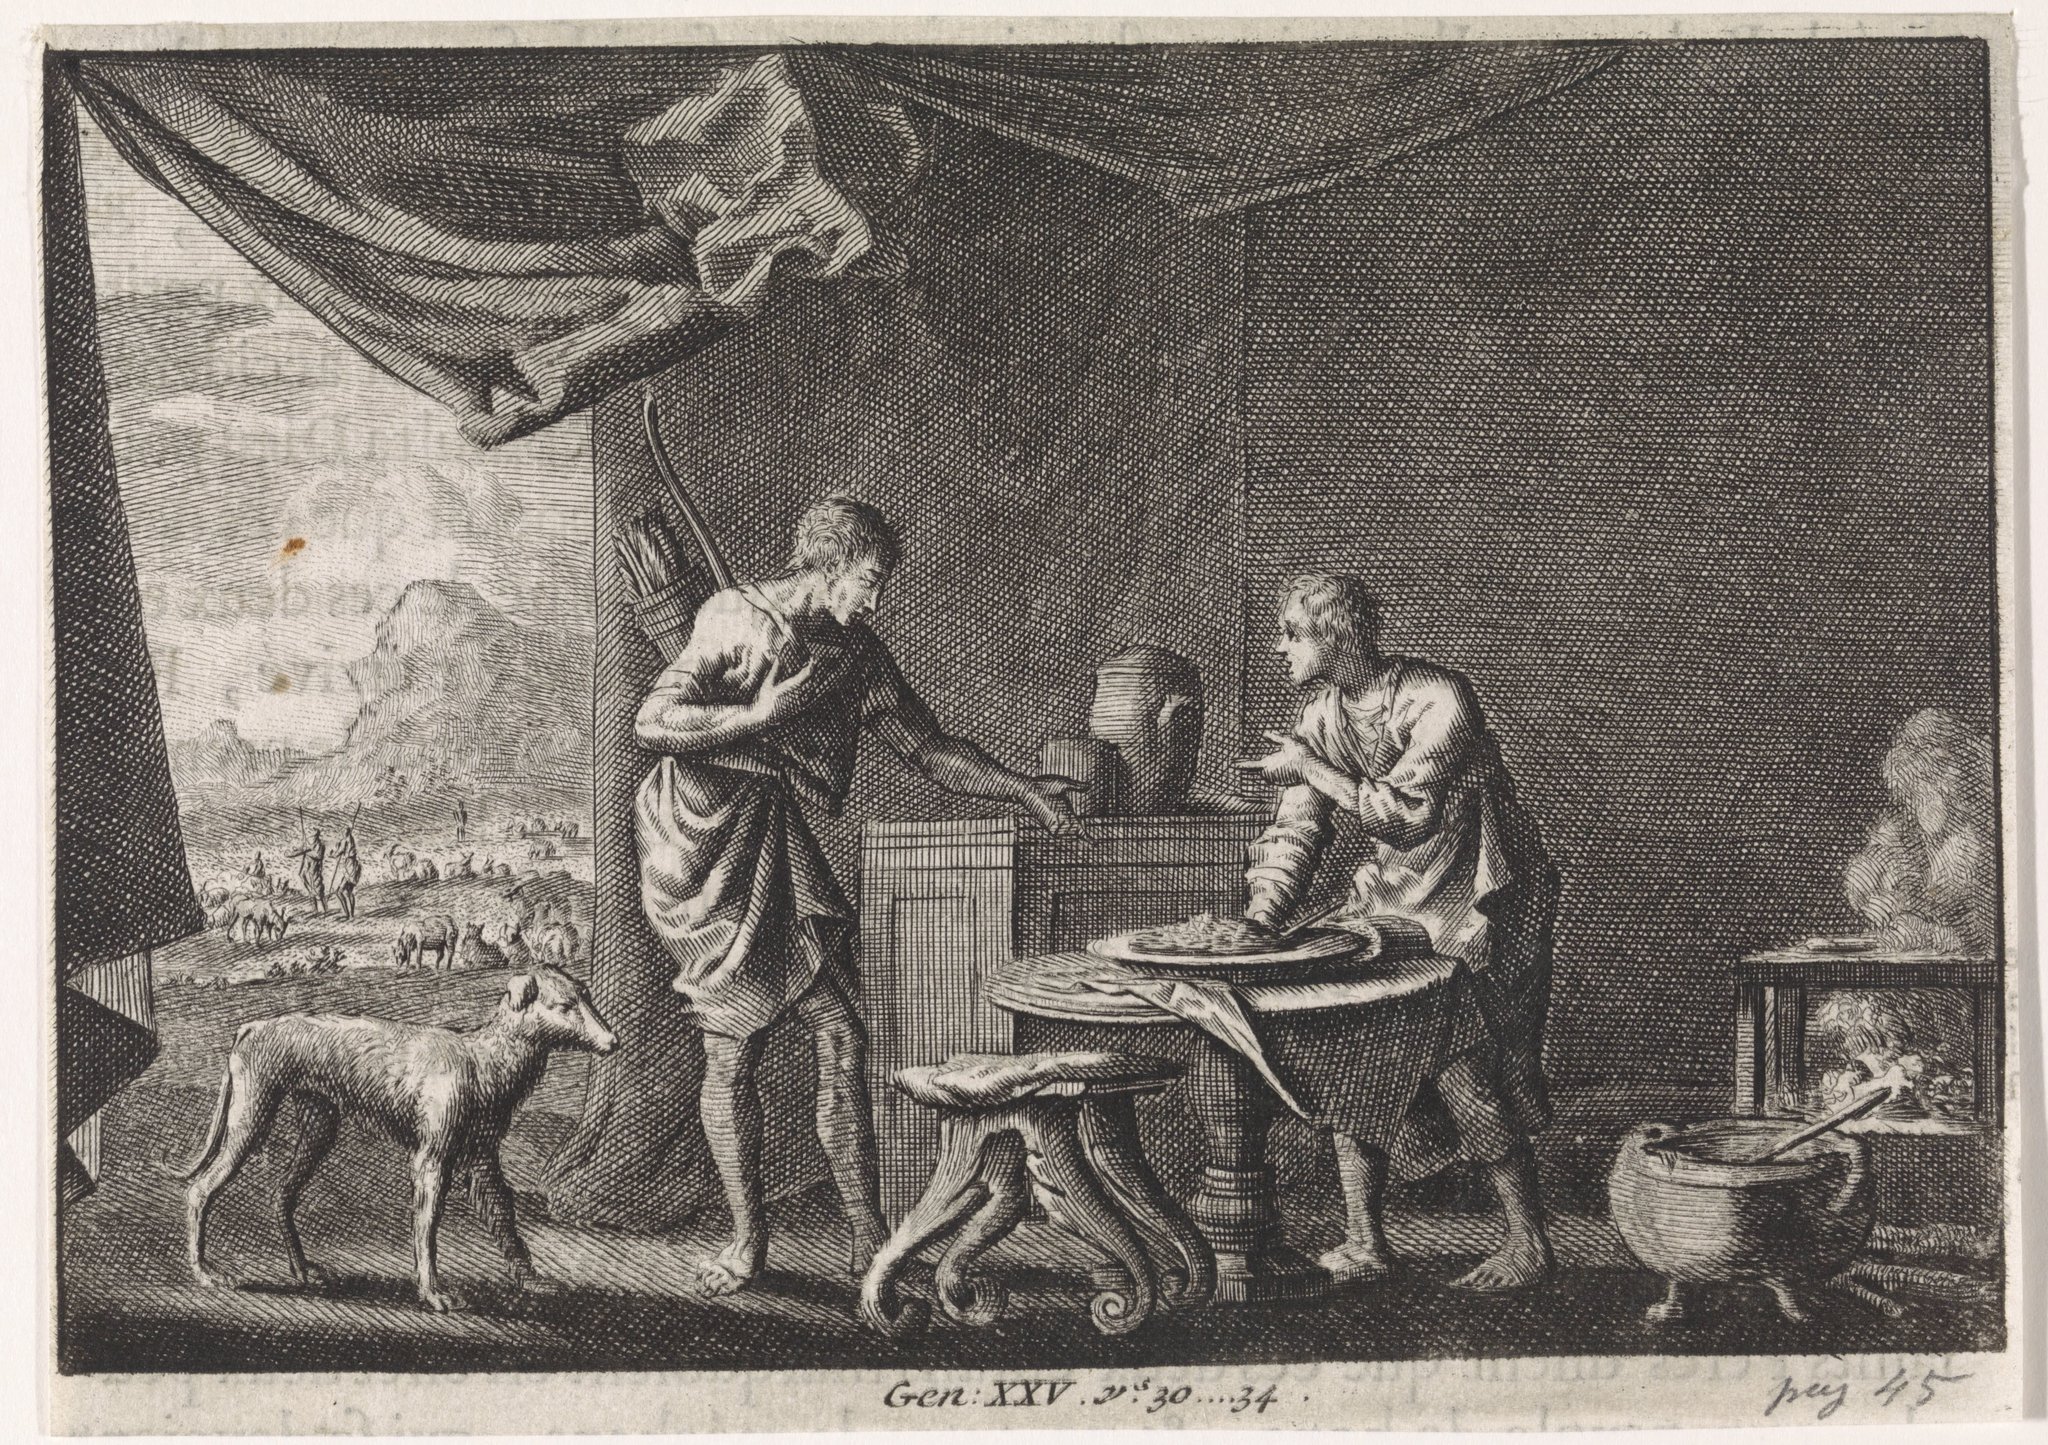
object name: book illustration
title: Esau verkoopt zijn eerstgeboorterecht aan Jakob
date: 1703-1762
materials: paper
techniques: etching, letterpress printing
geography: haarlem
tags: esau, returning hungry from the hunt, sells his first birthright to jacob for a pottage of lentils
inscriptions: collector's mark: Lugt 2228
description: De prent komt een eerste keer voor als boekillustratie voor David Martin. Historie des Ouden en Nieuwen Testaments. Amsterdam, Pieter Mortier, 1703. Deel I. De boekillustraties voor de Mortierbijbel hebben verschillende staten en kopieën, waarbij de chronologische volgorde moeilijk te achterhalen valt. Als boekillustraties werden ze bovendien herhaaldelijk opnieuw gebruikt voor andere boekwerken.